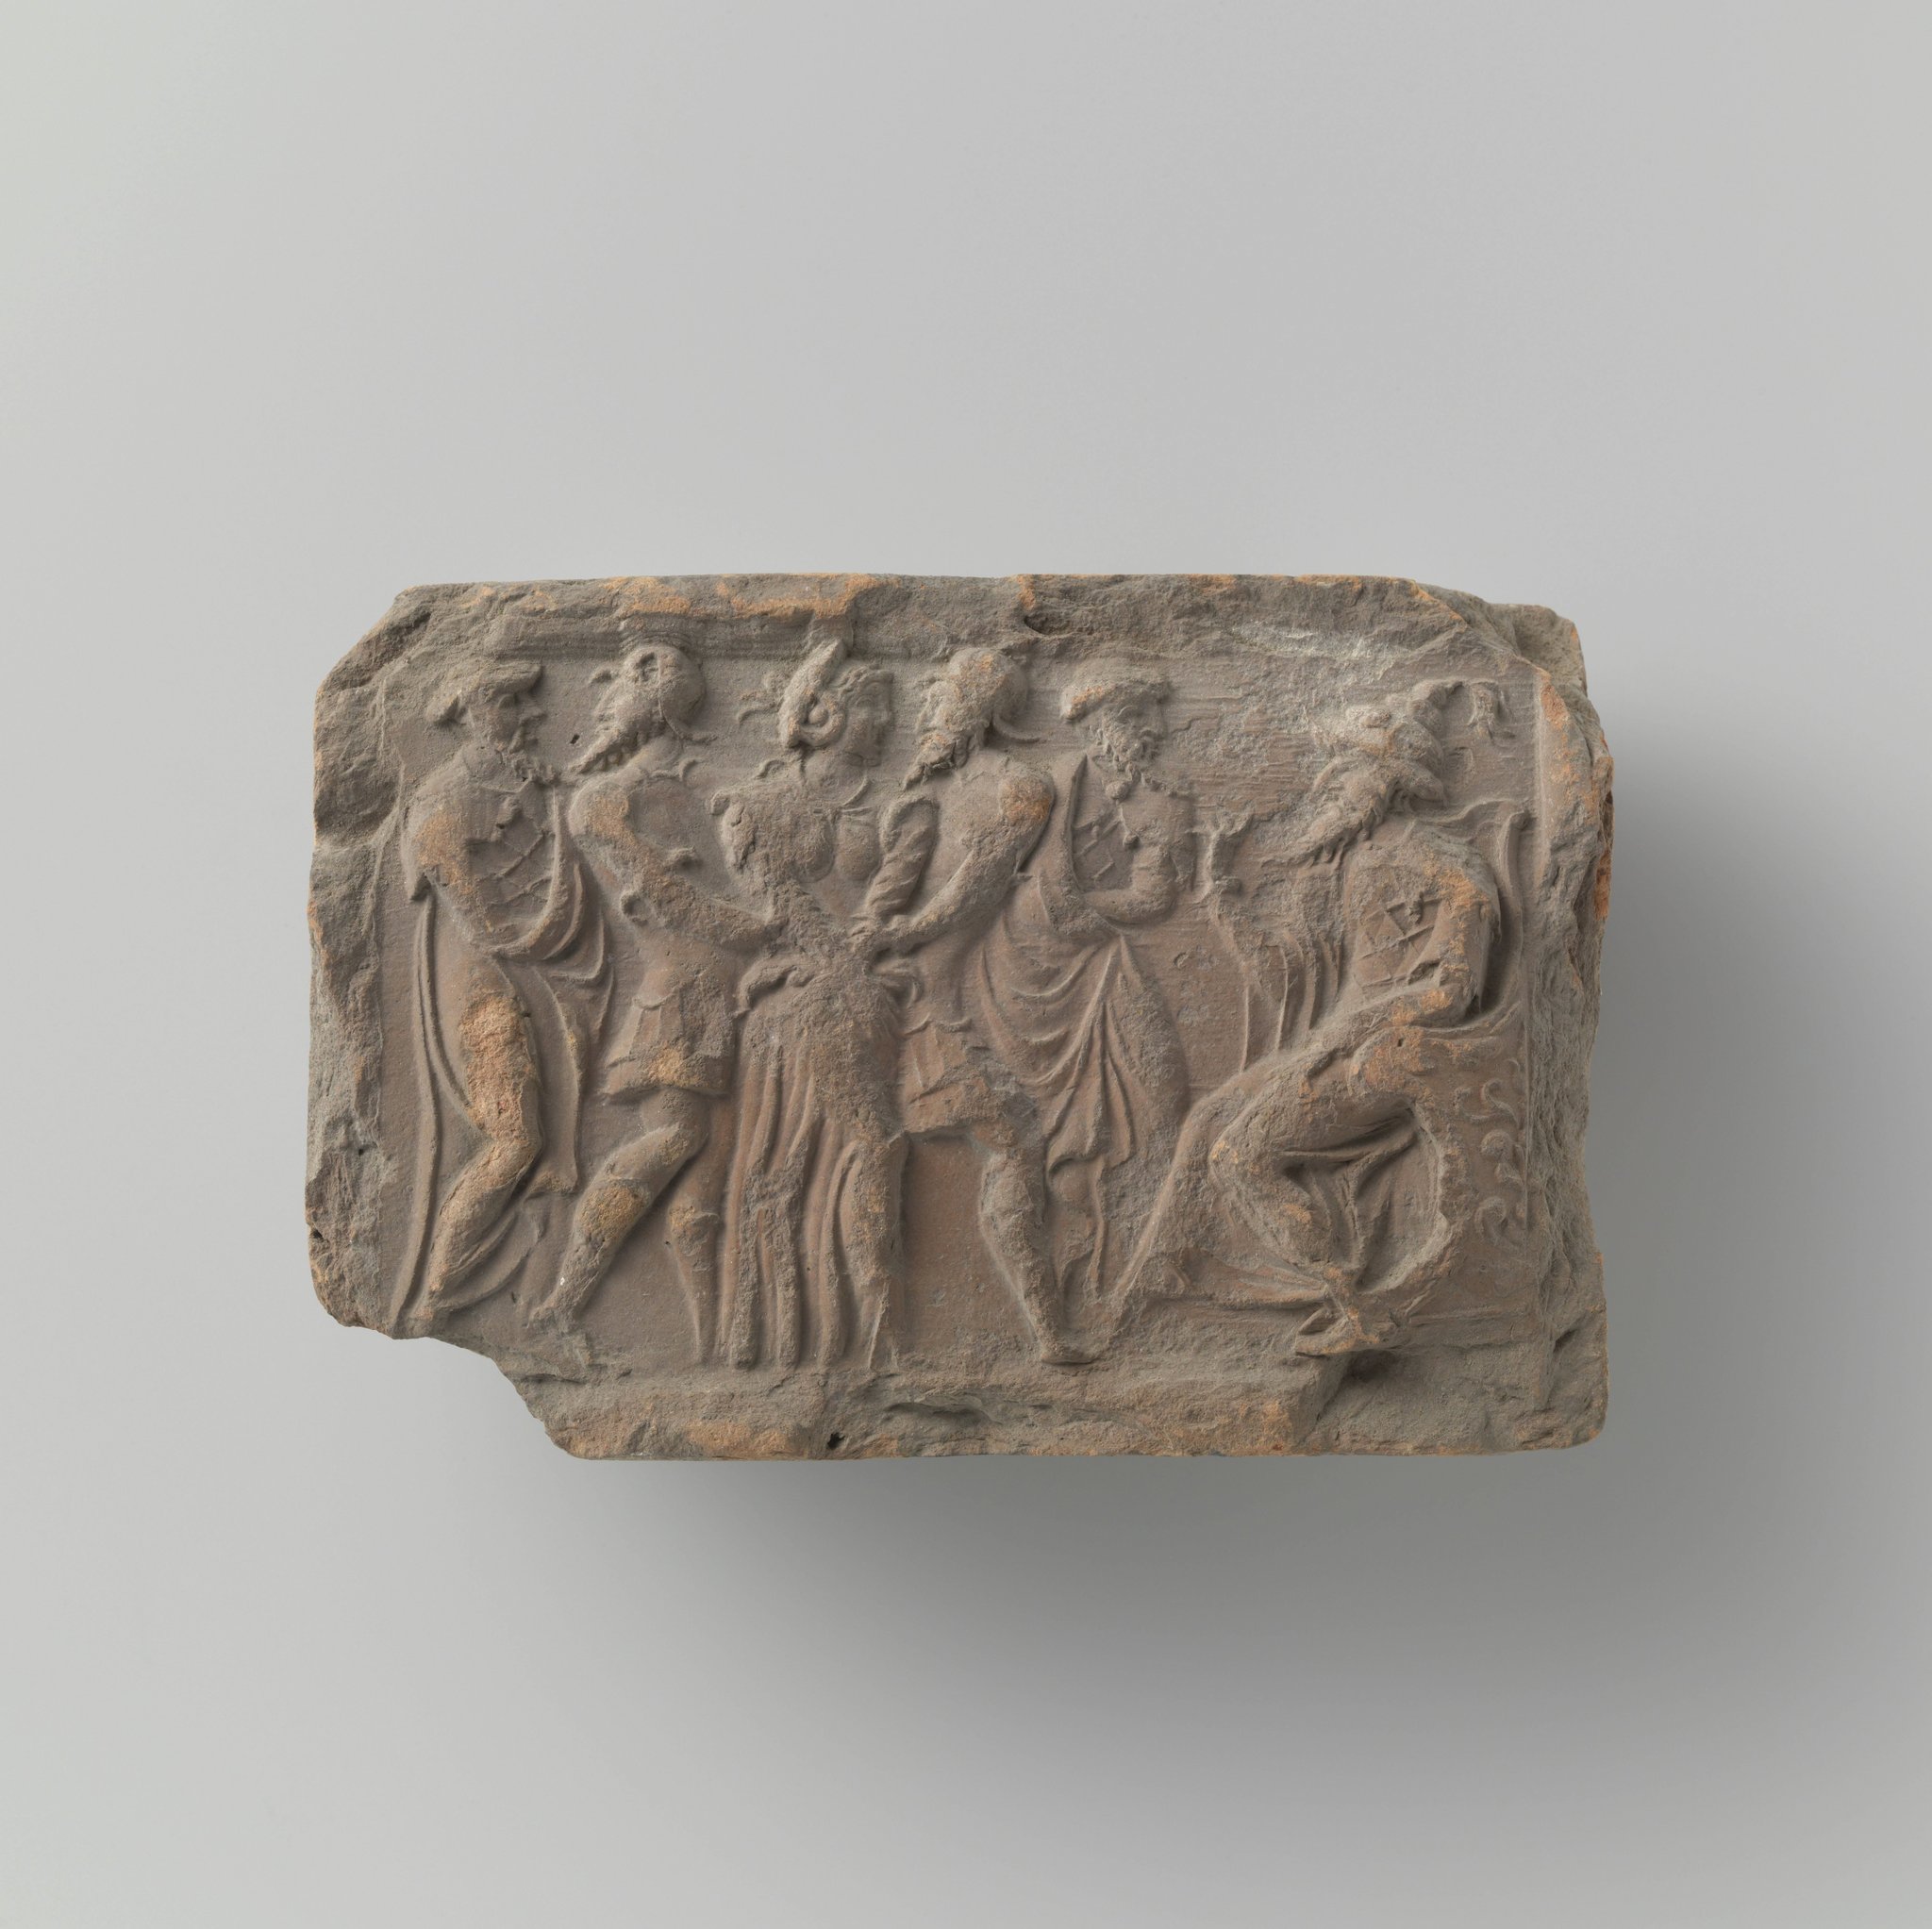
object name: hearthstone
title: Haardsteen met voorstelling van Suzanna, die door de twee ouderlingen voor de rechter wordt gevoerd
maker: Anonymous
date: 1400-1950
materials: earthenware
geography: southern netherlands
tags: the elders accusing susanna before the people, laying their hands on her head or unveiling her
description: Haardsteen met voorstelling van Suzanna, die door de twee ouderlingen voor de rechter wordt gevoerd. Geschonden.